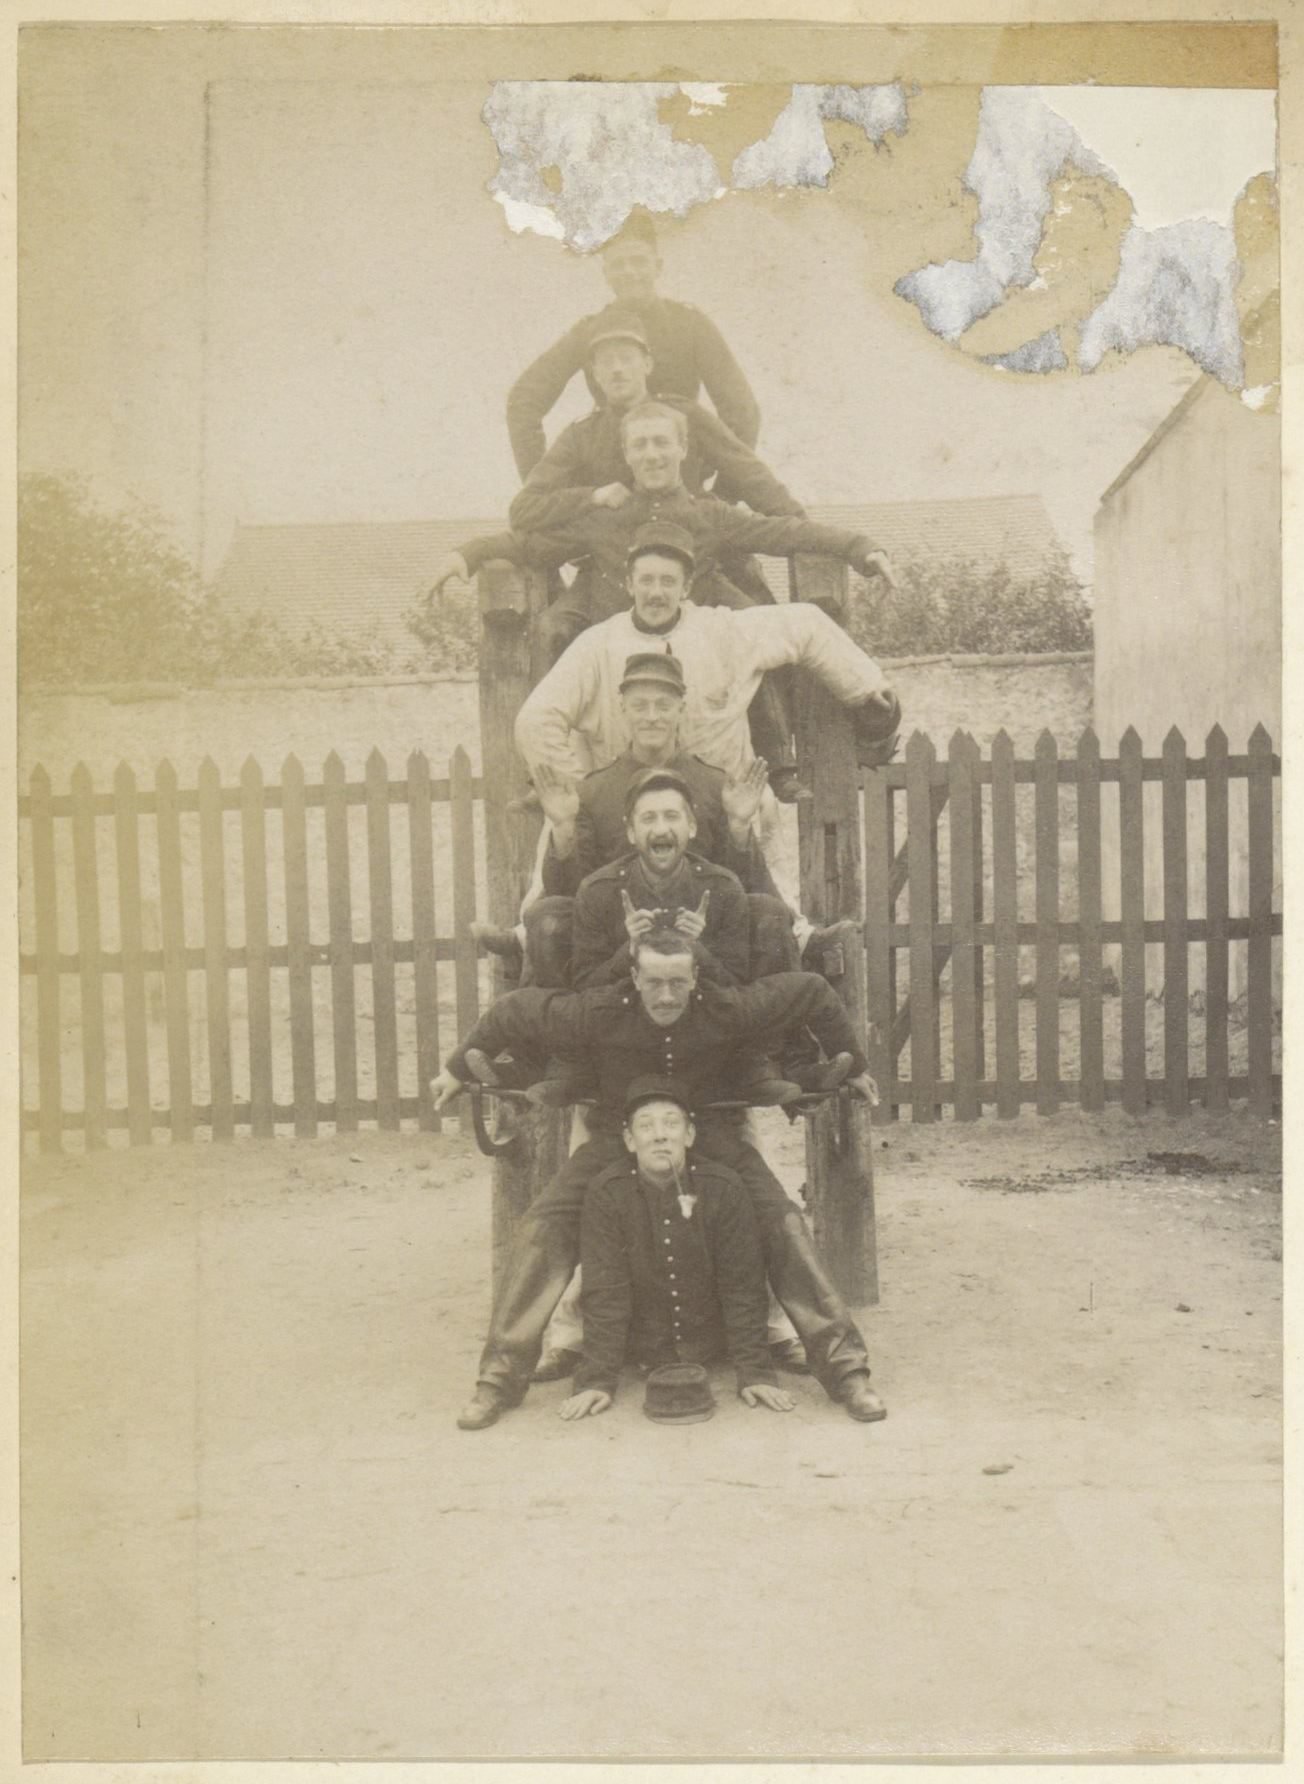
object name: photograph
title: Groepsportret van militairen in Frankrijk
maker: Anonymous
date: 1900-1910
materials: paper, photographic support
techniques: albumen print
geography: france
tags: land forces, france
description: Onderdeel van Fotoalbum van een Franse amateurfotograaf met opnames van een familie, distilleerderij Delizy & Doistau Fils, het leger en bezienswaardigheden in Frankrijk.